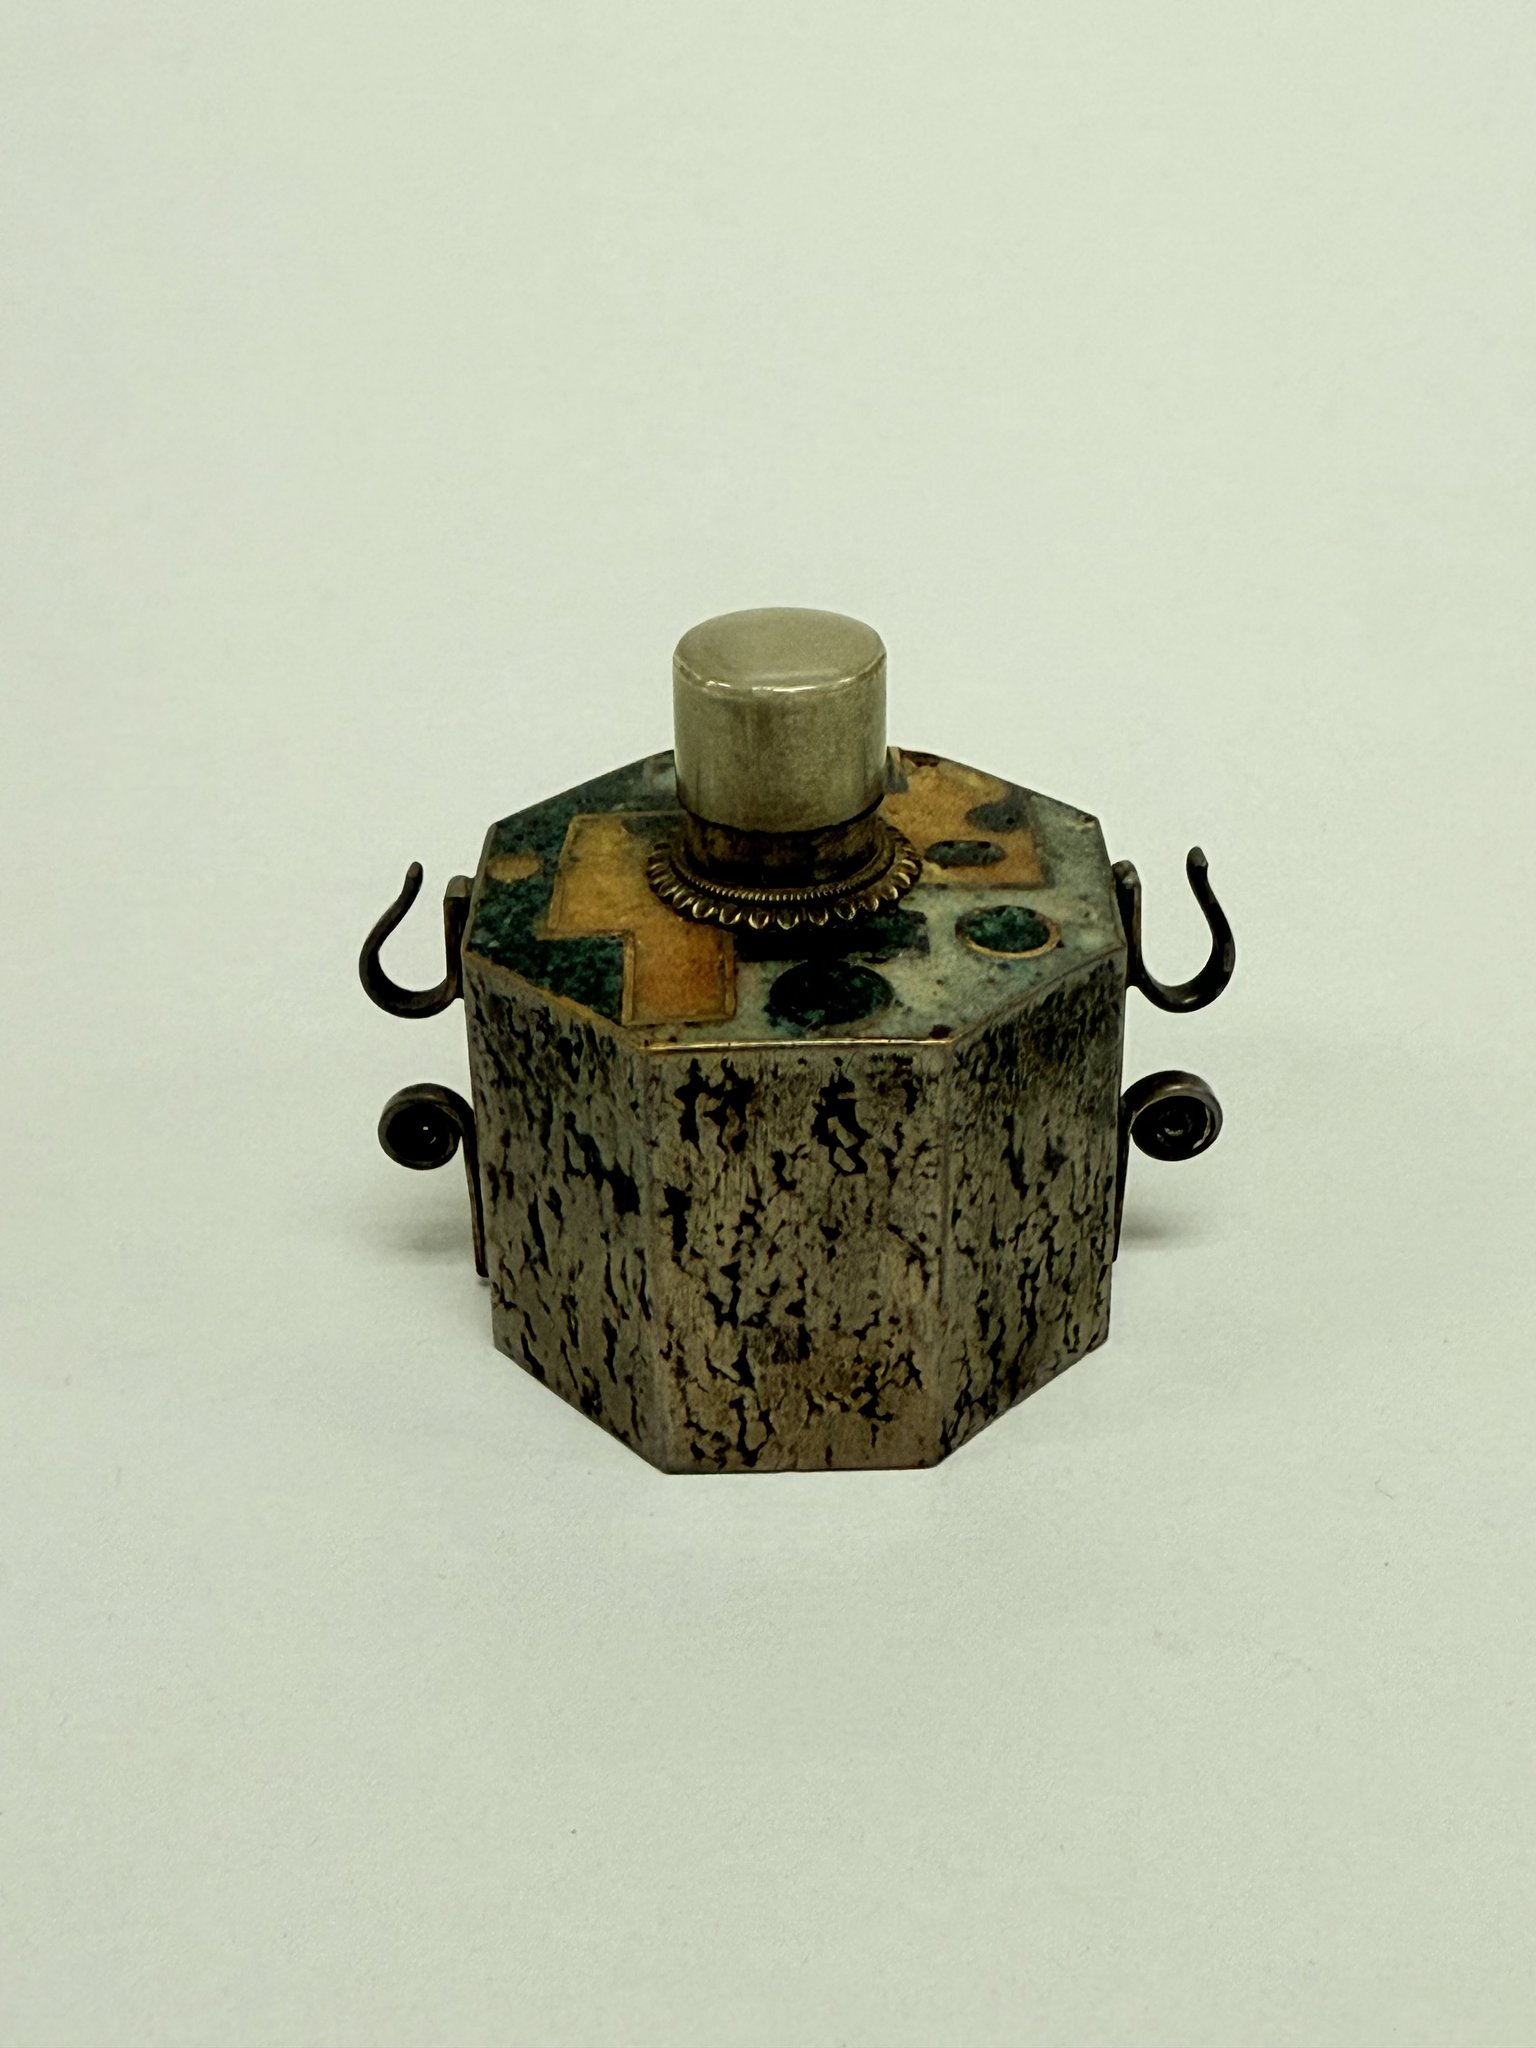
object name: water bottle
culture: japanese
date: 1801-1900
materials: silver